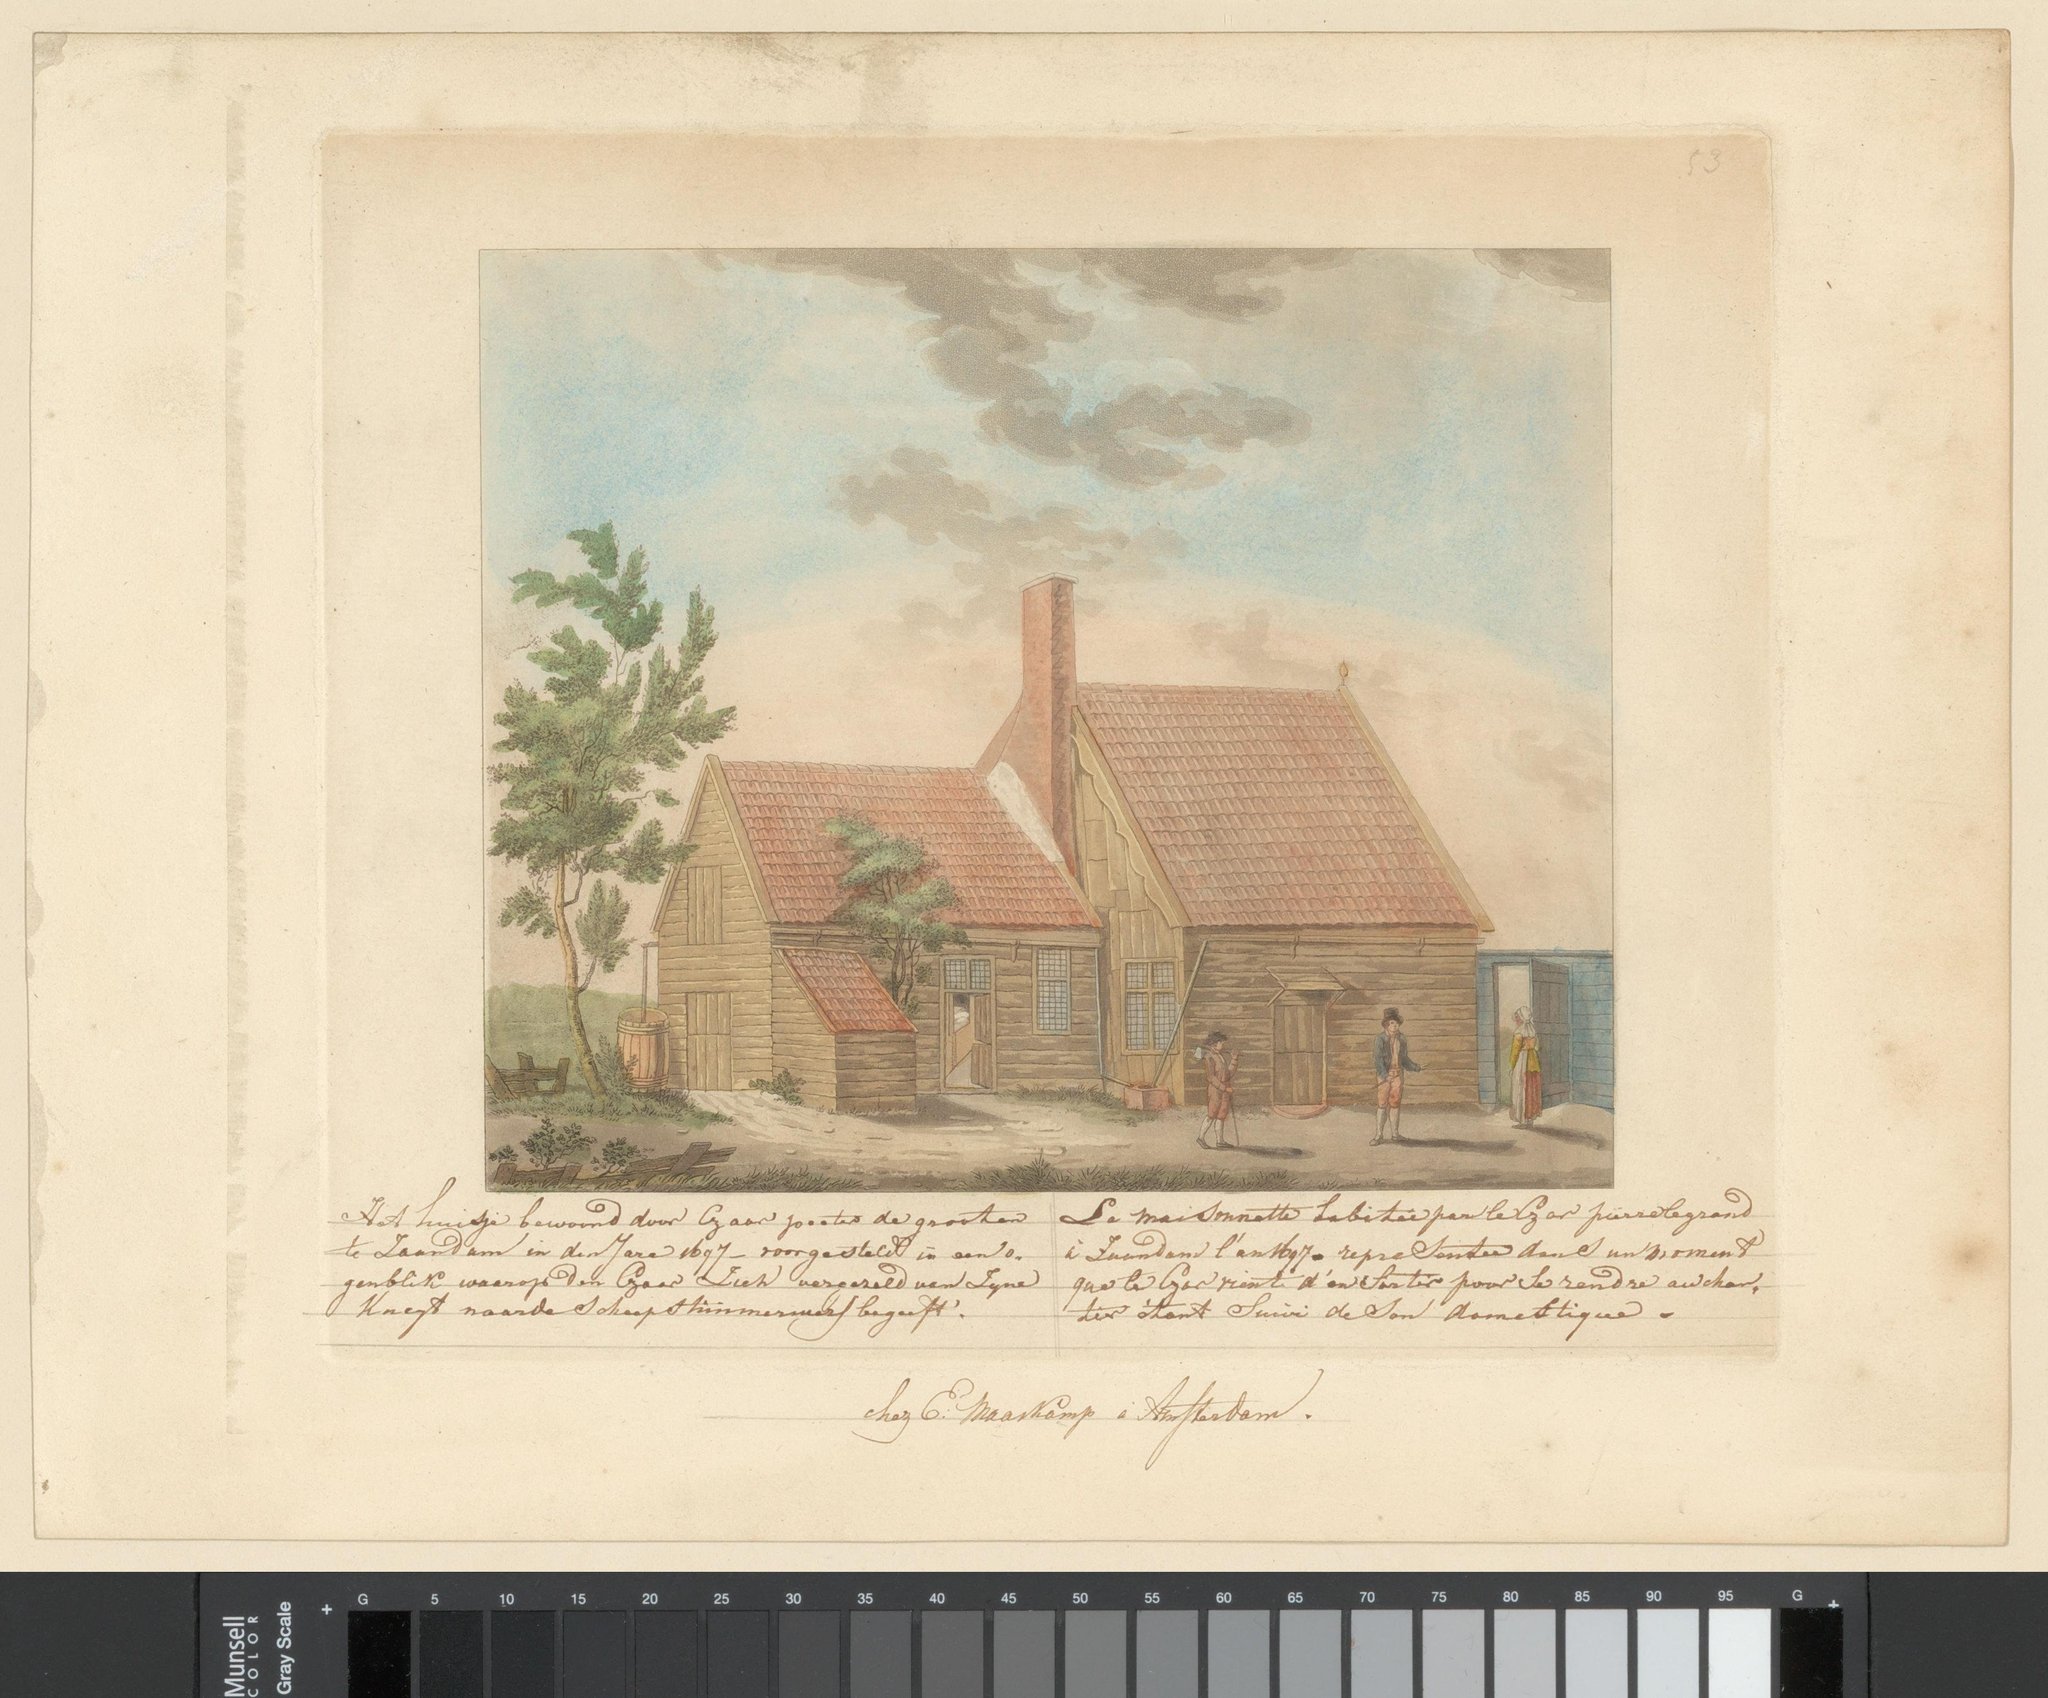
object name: print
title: Tsaar Peterhuisje te Zaandam, 1820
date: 1824-1825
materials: paper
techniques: aquatint, etching, hand coloring, writing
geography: amsterdam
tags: emperor, cottage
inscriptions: stamp, collector's mark: Lugt 1641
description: Tsaar Peter begeeft zich met zijn knecht van het Tsaar Peterhuisje te Zaandam naar de scheepstimmerwerf, augustus 1697. Onderwerpsrubrieken binnen de Atlas Zeden en Gewoonten: Handel, Nijverheid en Verkeer, Scheepsbouw.